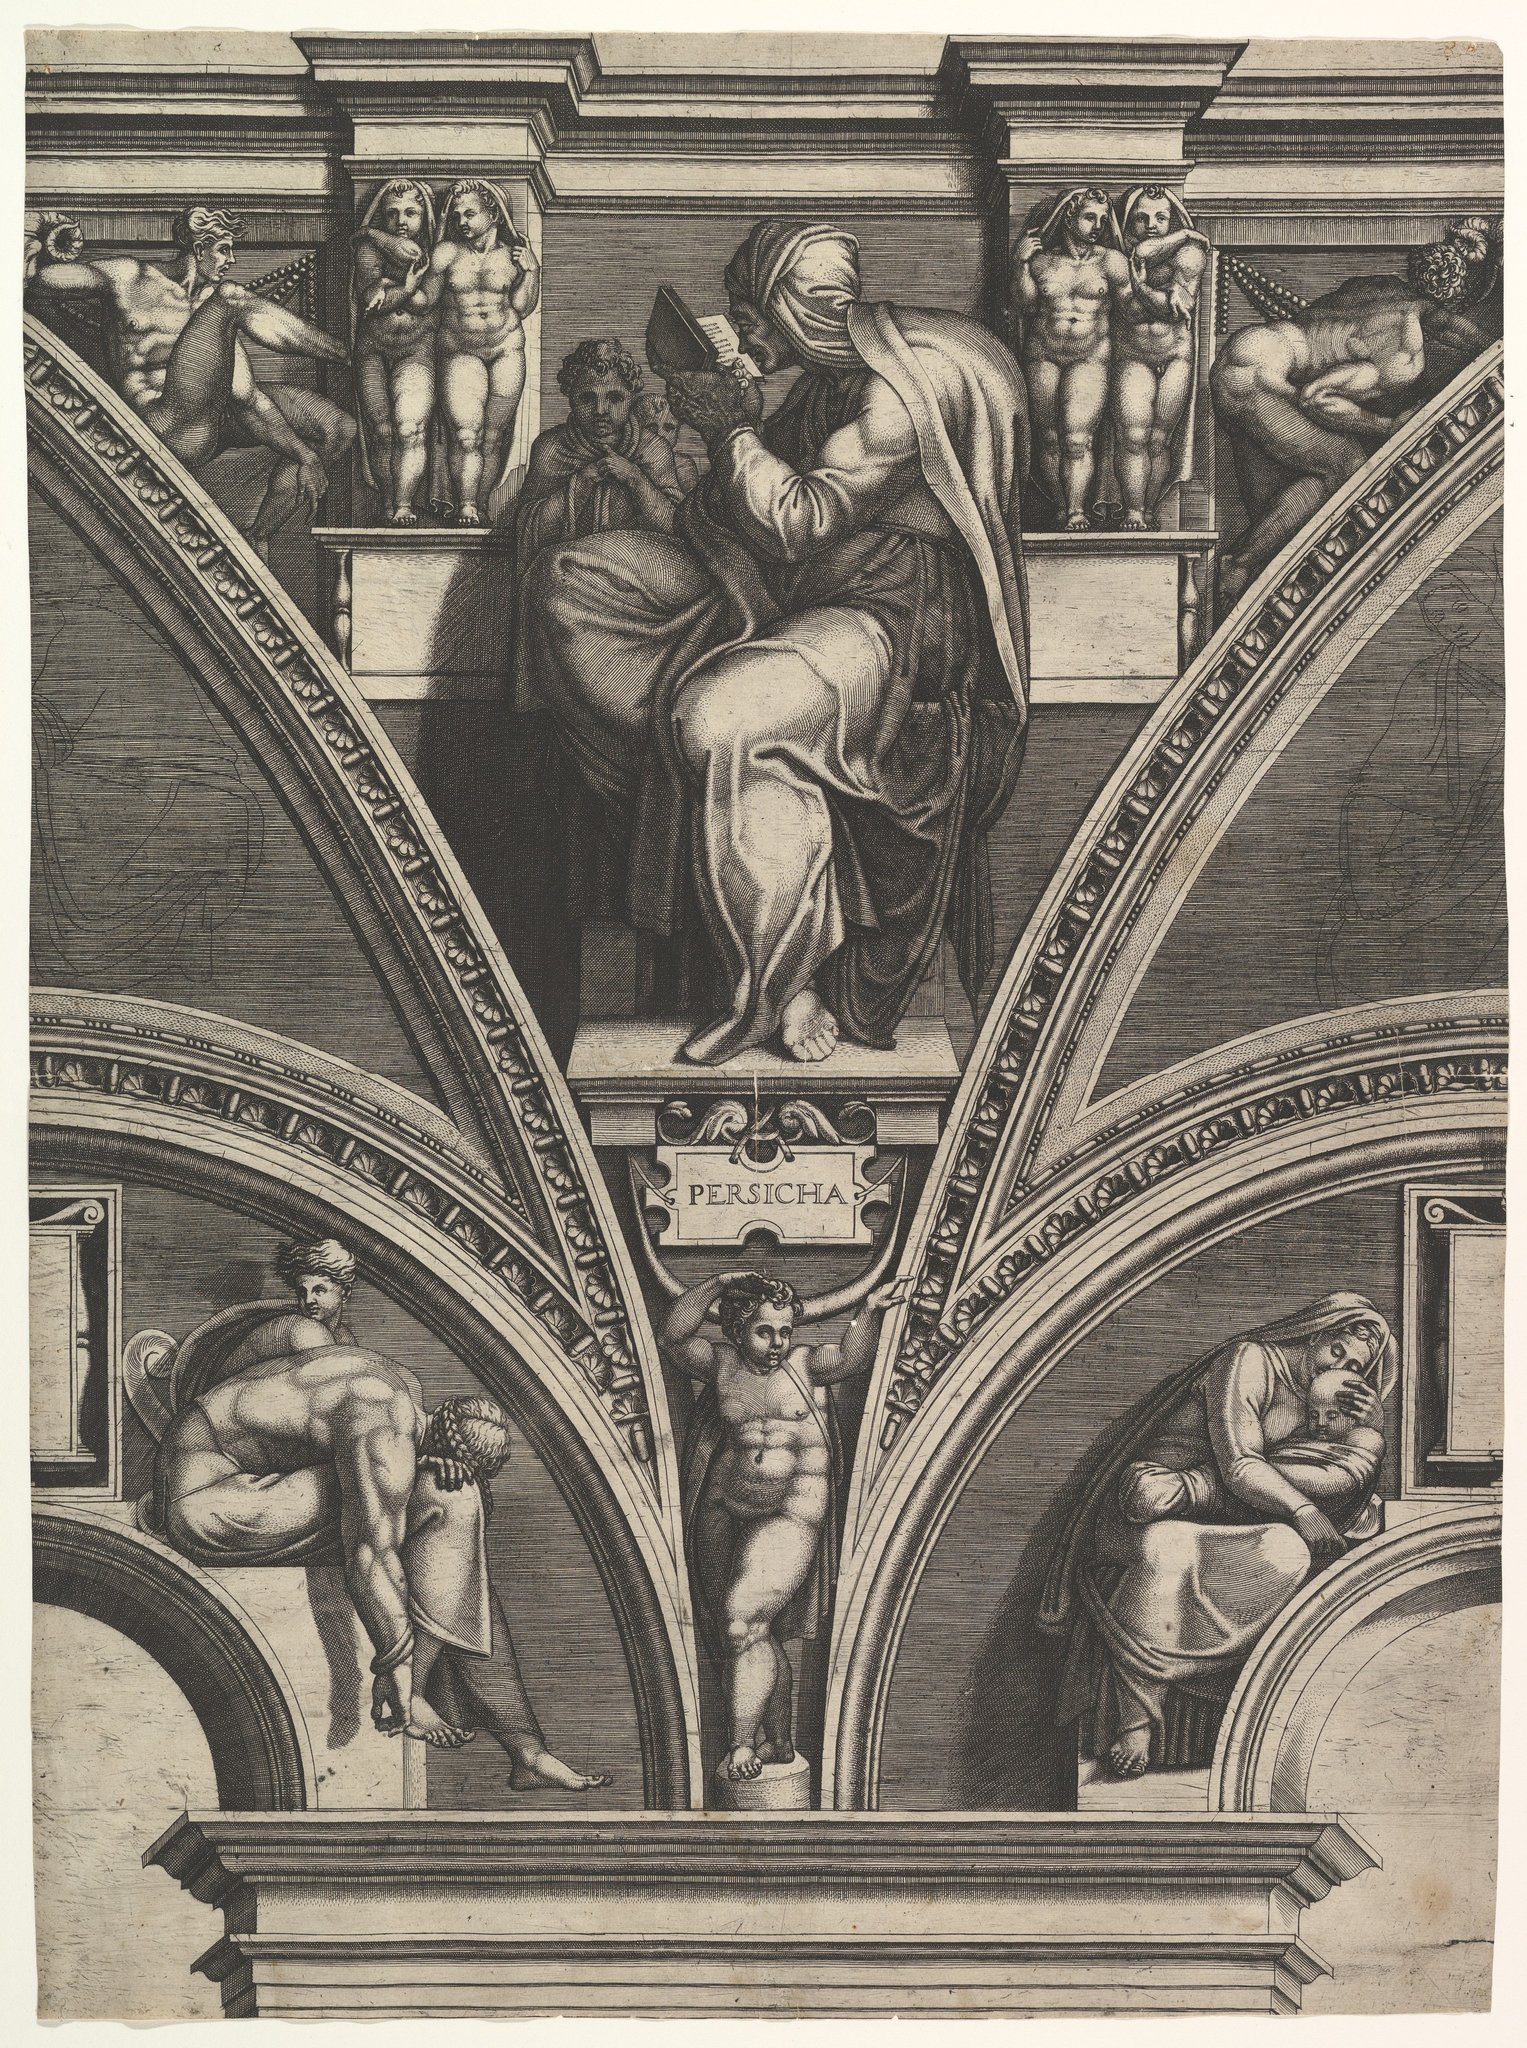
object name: print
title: The Persian Sibyl; from the series of Prophets and Sibyls in the Sistine Chapel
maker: giorgio ghisi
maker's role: artist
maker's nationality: italian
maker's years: 1515-1582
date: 1570-1575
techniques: engraving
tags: men,male nudes,sibyl